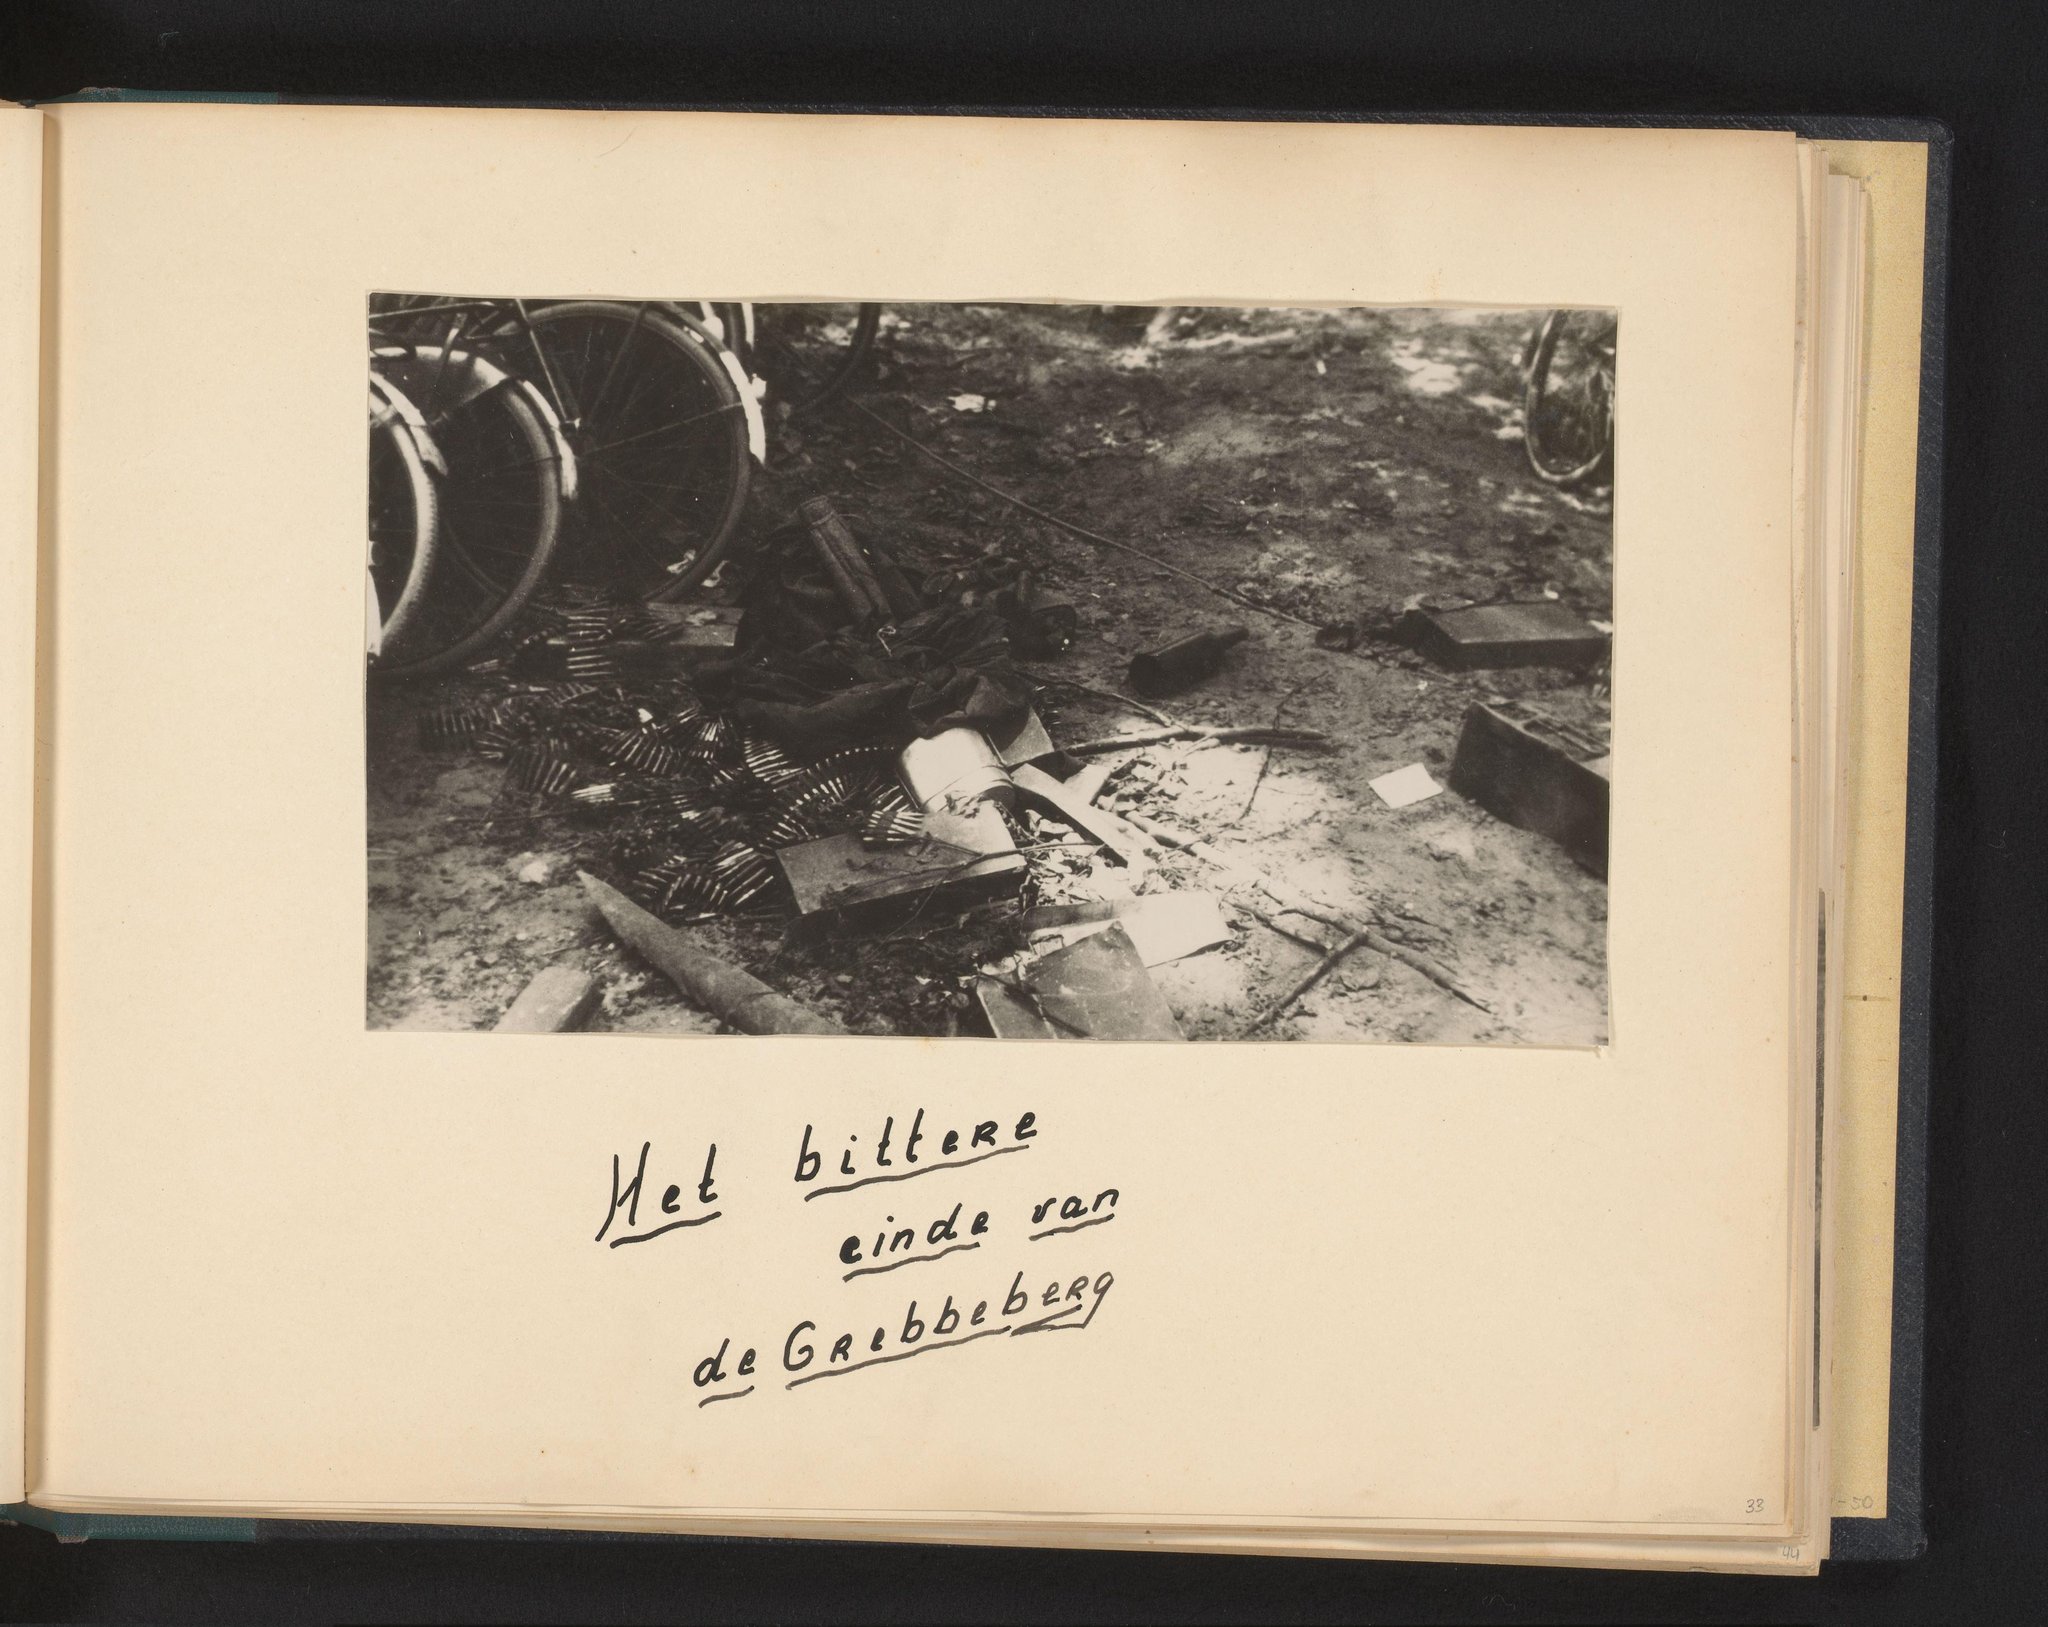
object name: album leaf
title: Het bittere einde van de Grebbeberg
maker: Anonymous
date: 1940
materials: cardboard, paper, photographic support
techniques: gelatin silver print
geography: netherlands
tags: ammunition, the defeated (after the battle), netherlands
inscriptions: inscription: ‘Het bittere einde van de Grebbeberg’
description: Albumblad met een foto van patronen en ander materieel liggend op de grond naast enkele fietsen. Overgebleven na de slag bij de Grebbeberg 11-13 mei 1940. Onderdeel van het fotoalbum over de verwoestingen van Nederlandse steden en infrastructuur in het begin van de Tweede Wereldoorlog.